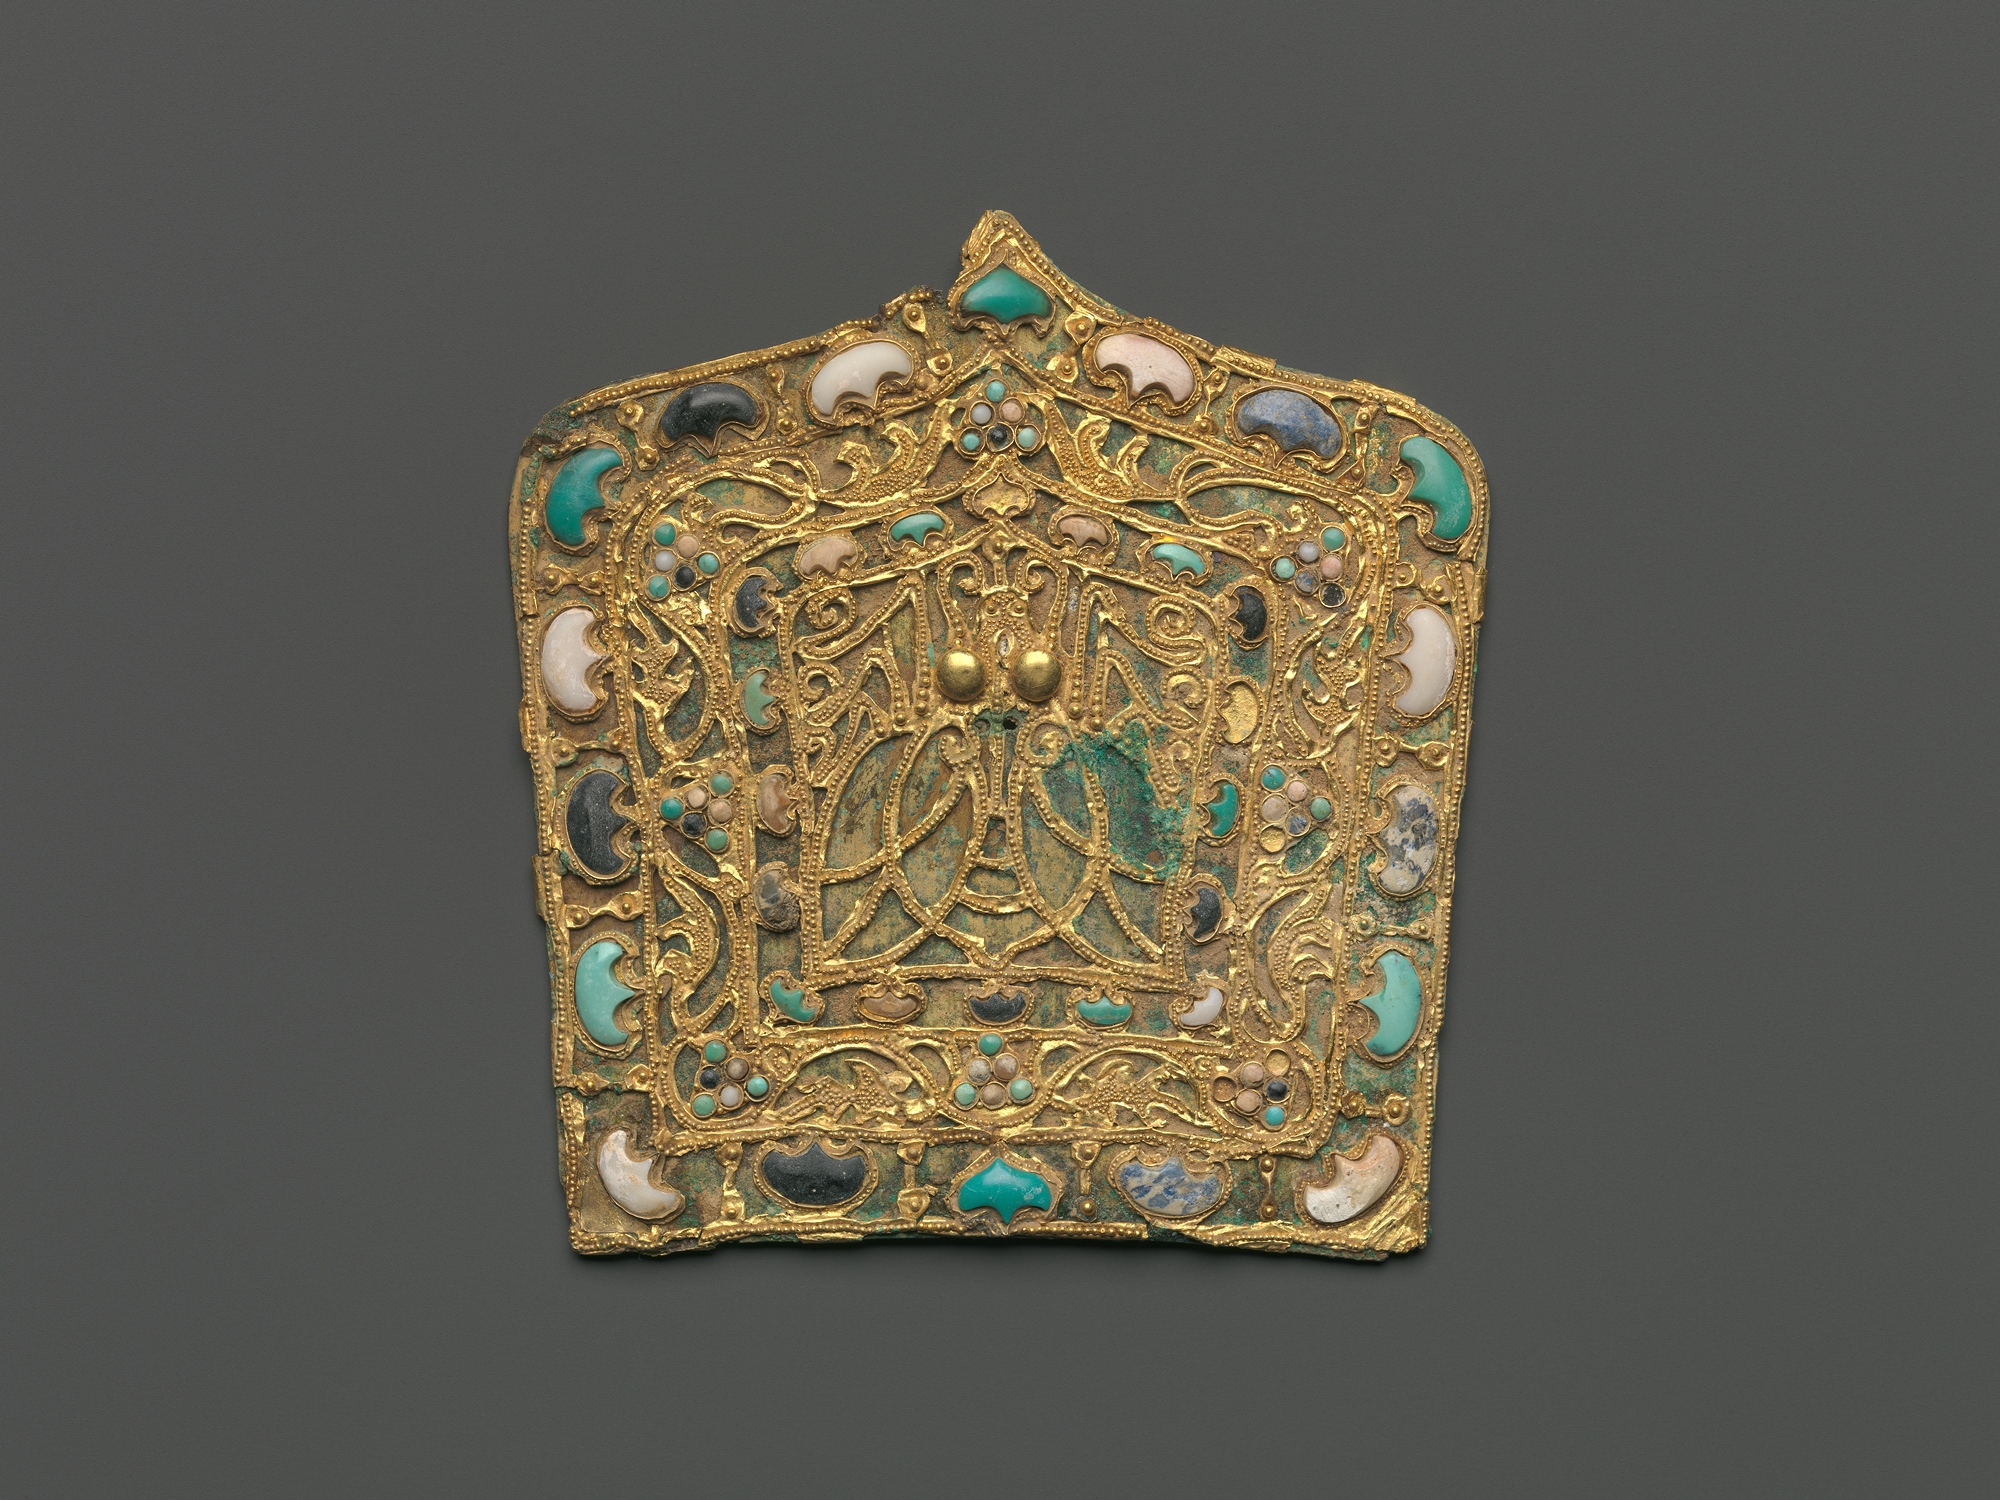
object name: plaque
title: Ornamental Plaque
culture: chinese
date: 301-500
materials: coral, gilt bronze, gold, lapis lazuli